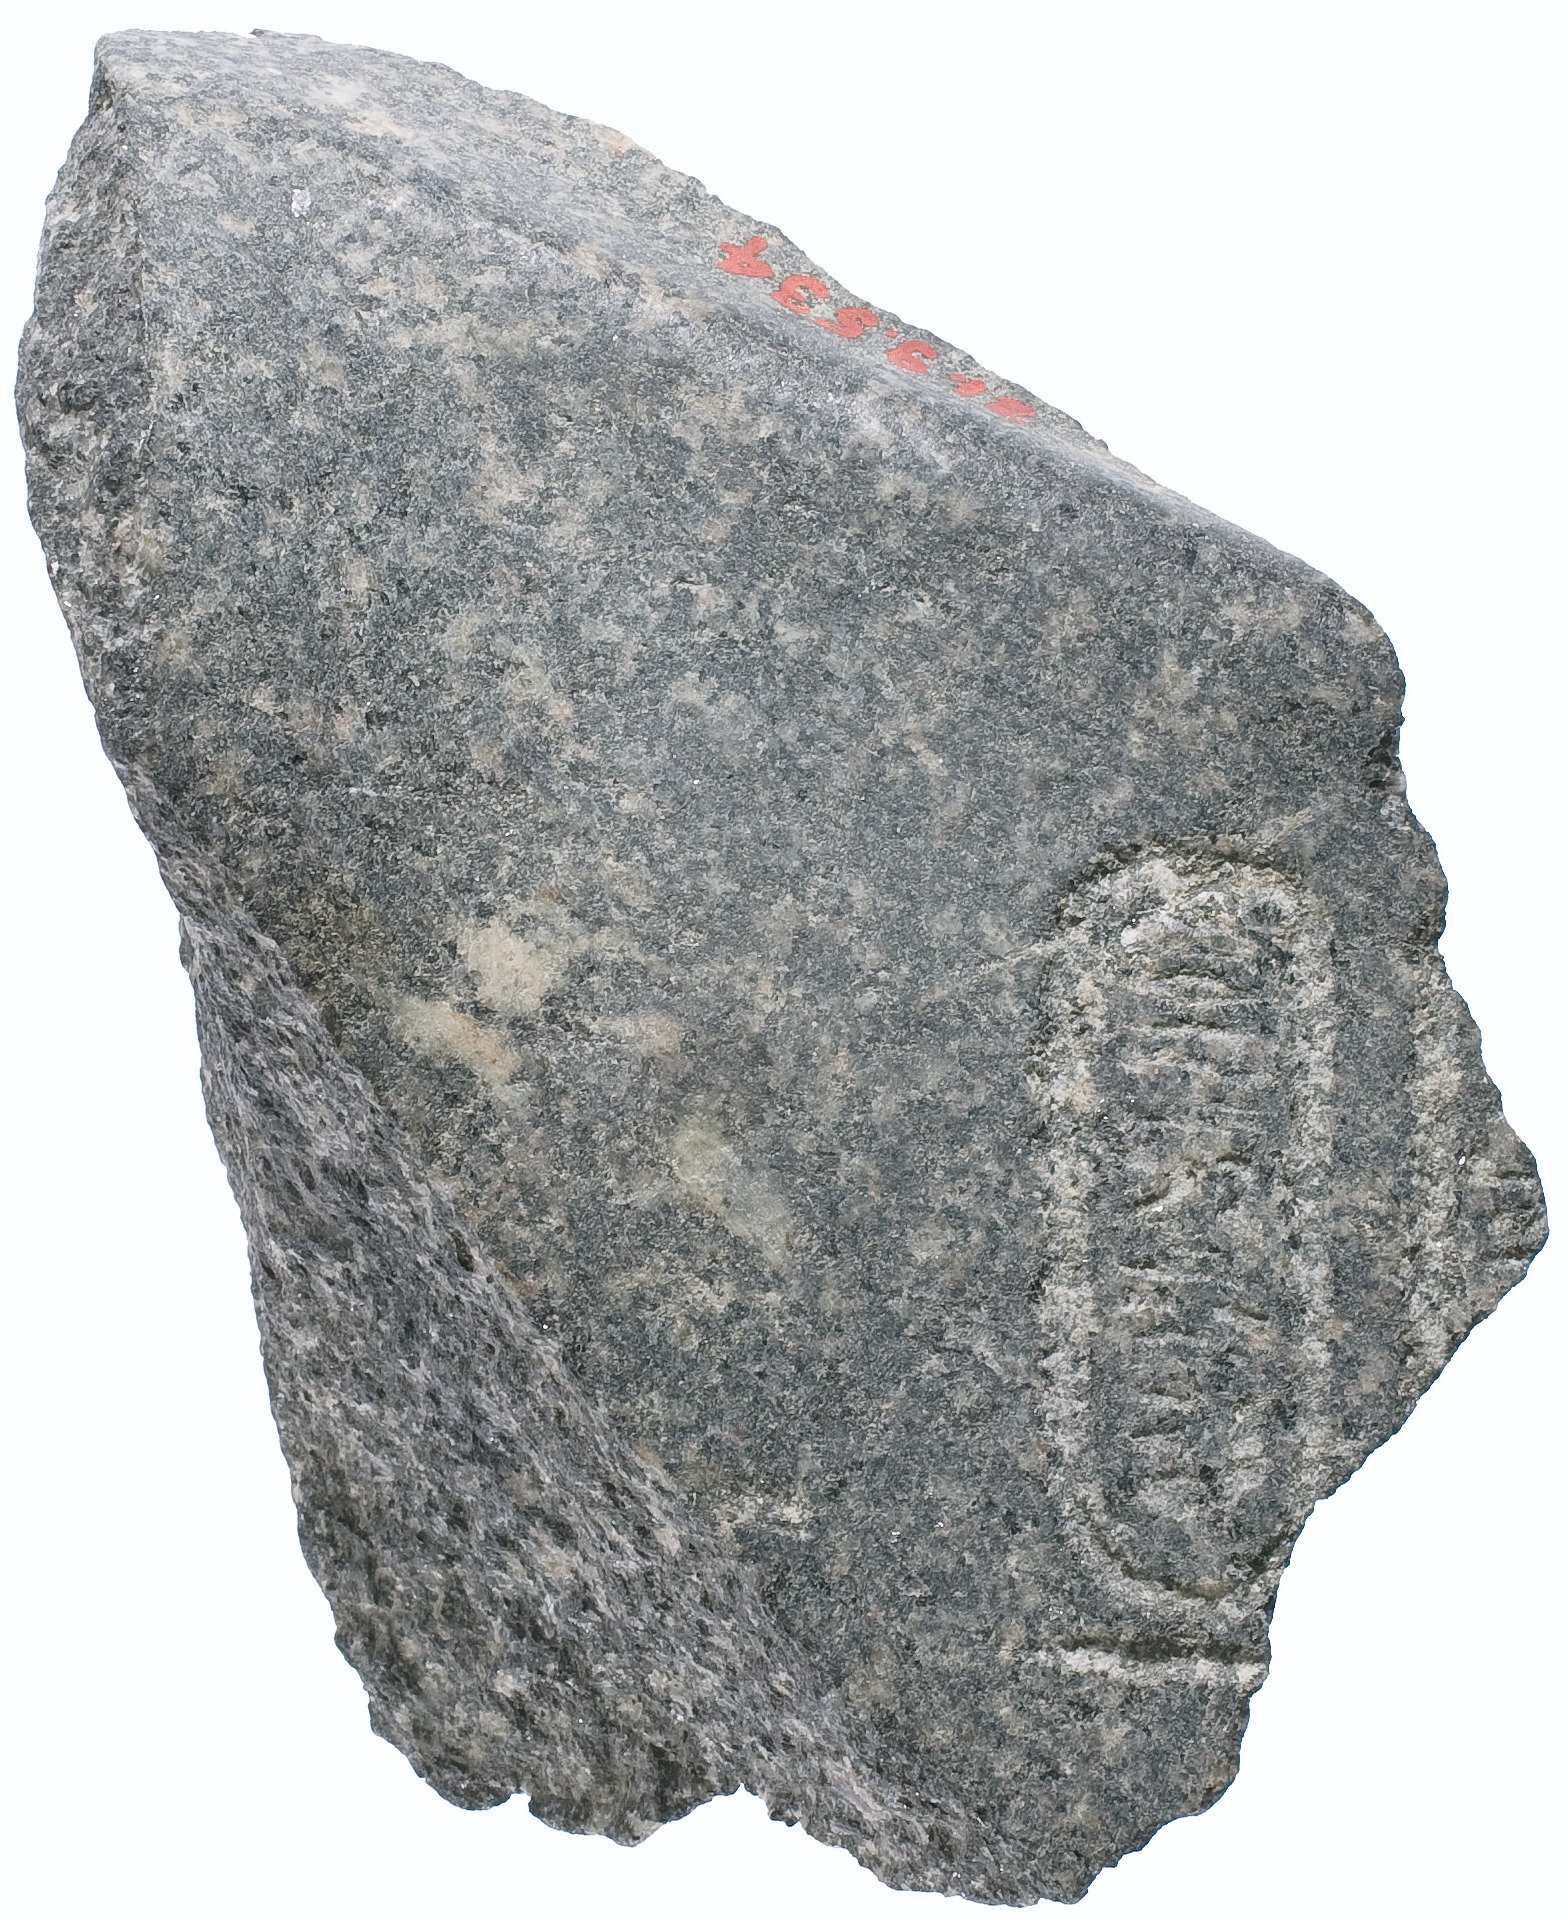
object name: right chest and shoulder, aten cartouch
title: Right shoulder and chest with Aten cartouches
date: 1353-1336 BCE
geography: egypt